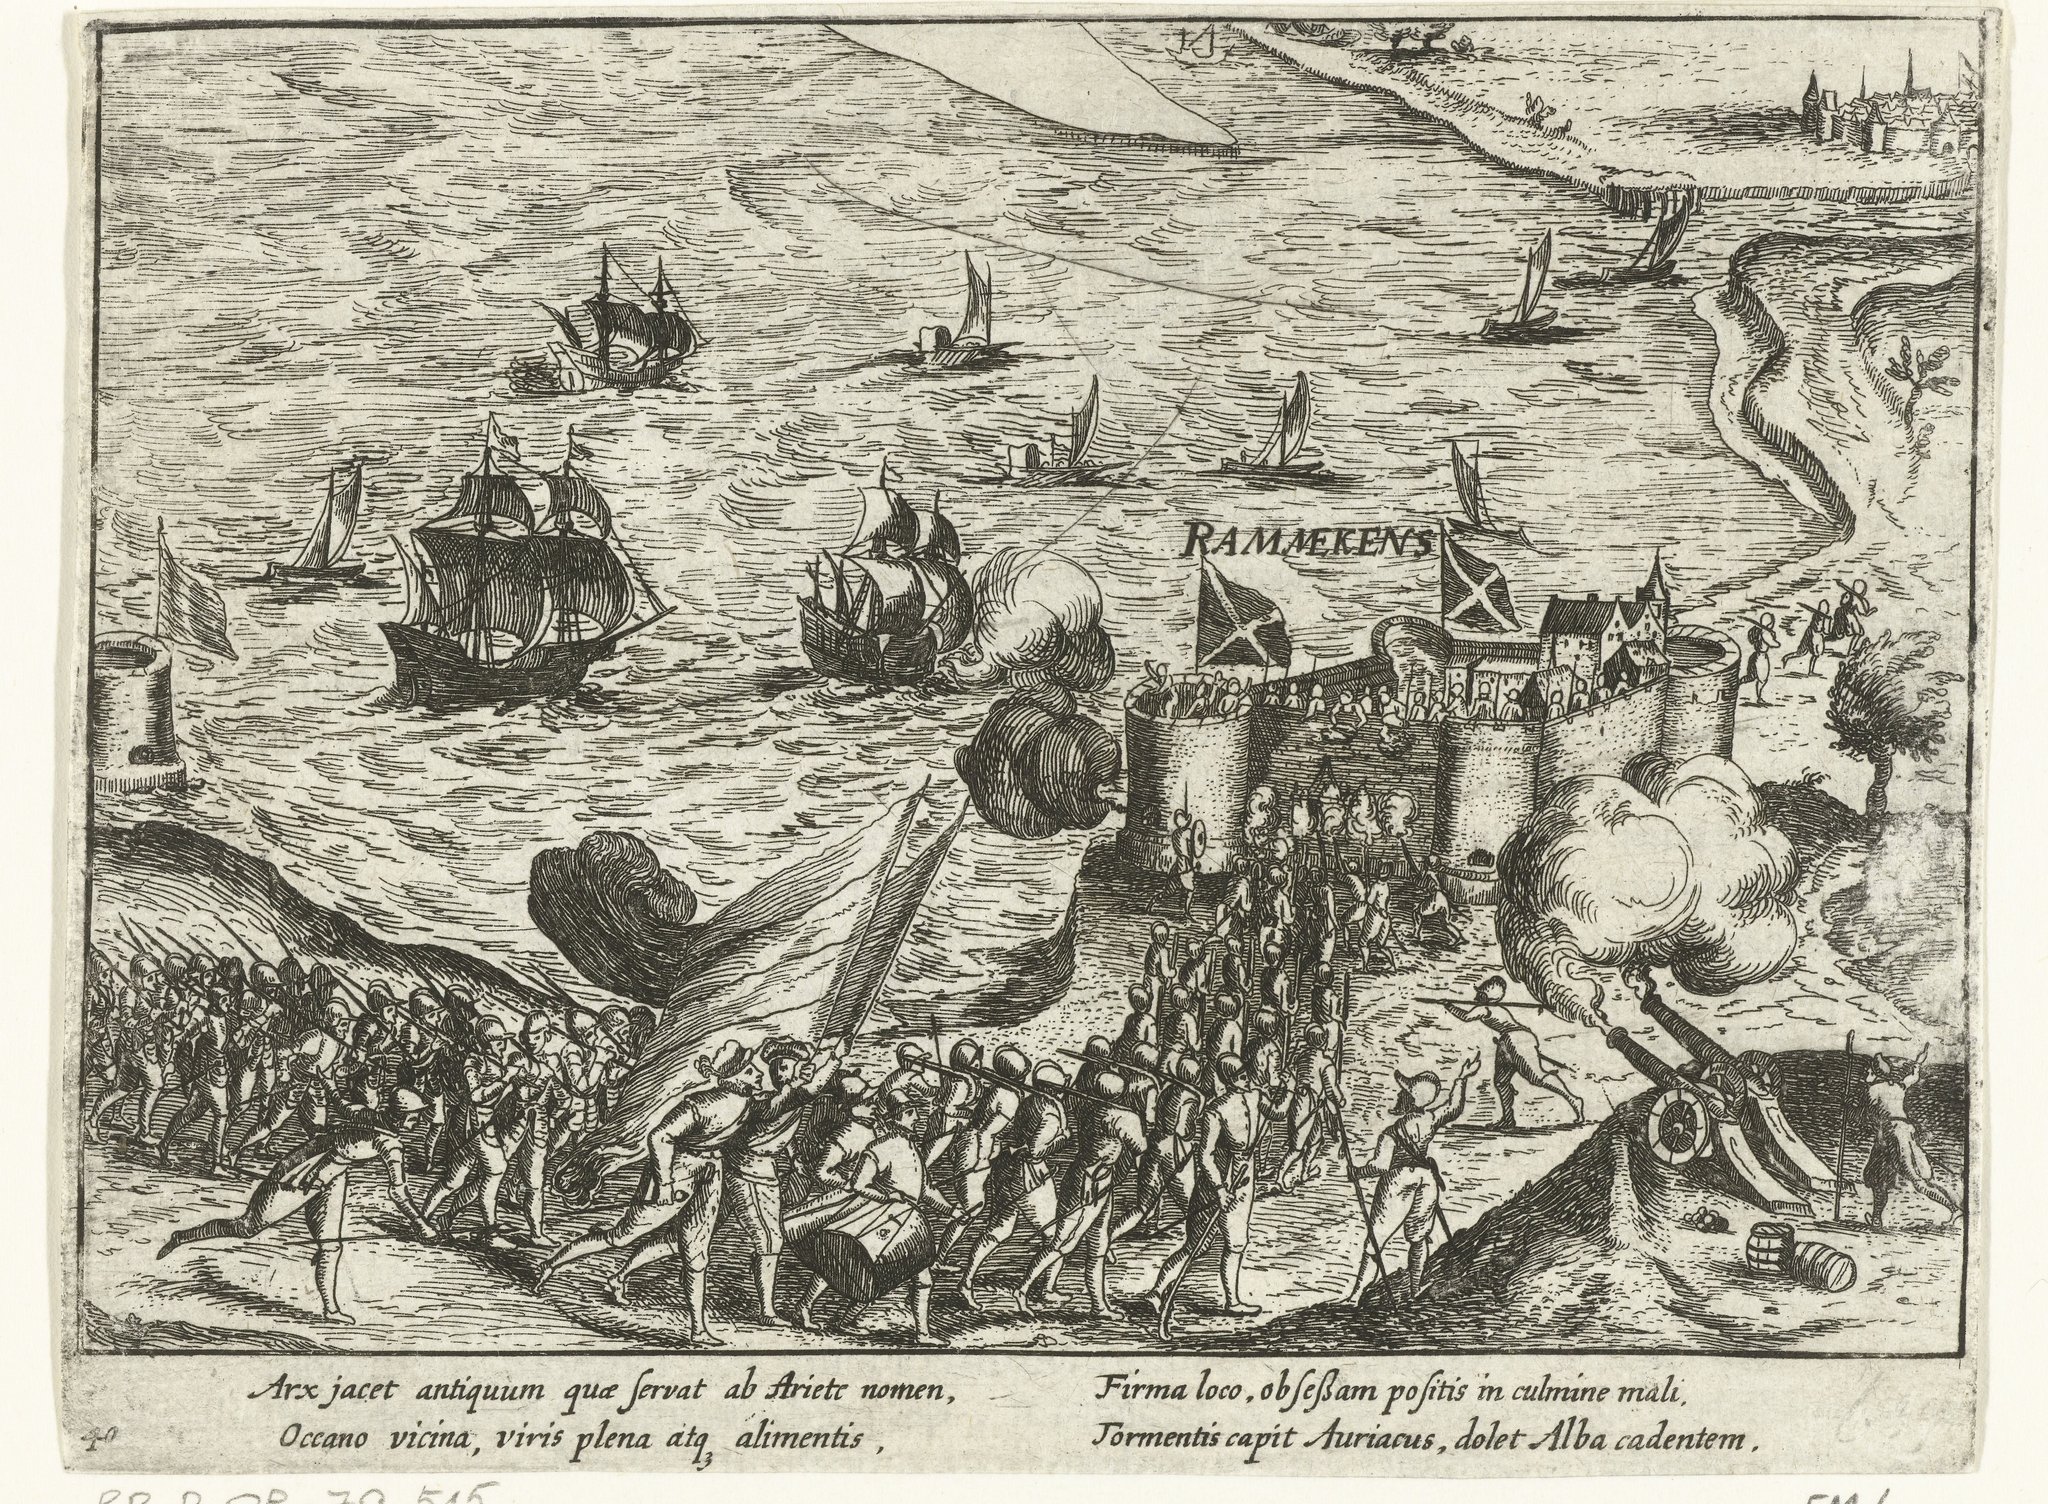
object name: print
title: Fort Rammekens ingenomen, 1573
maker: Anonymous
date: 1613-1615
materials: paper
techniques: etching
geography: northern netherlands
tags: brussels, capture of city (after the siege)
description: Fort Rammekens in Zeeland ingenomen door watergeuzen onder bevel van Charles en Louis de Boisot, 5 augustus 1573. Met onderschrift van 4 regels in het Latijn. Genummerd: 40. Bedrukt op achterzijde met tekst in het Latijn.